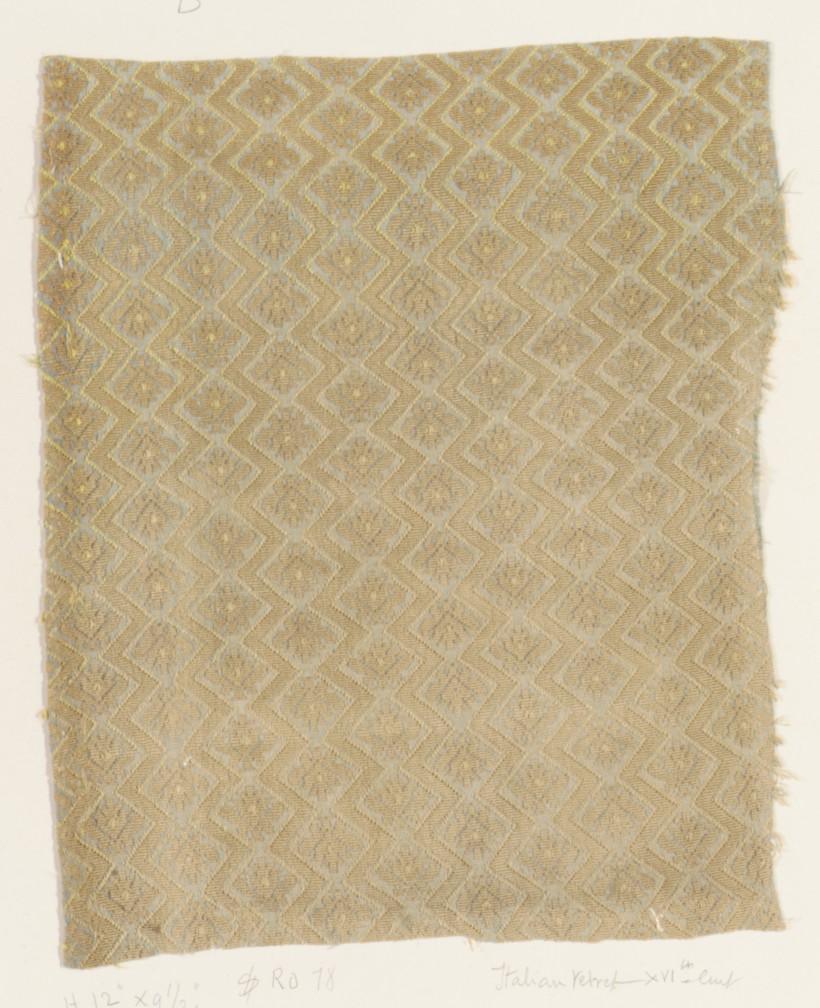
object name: fragment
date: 1501-1600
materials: silk